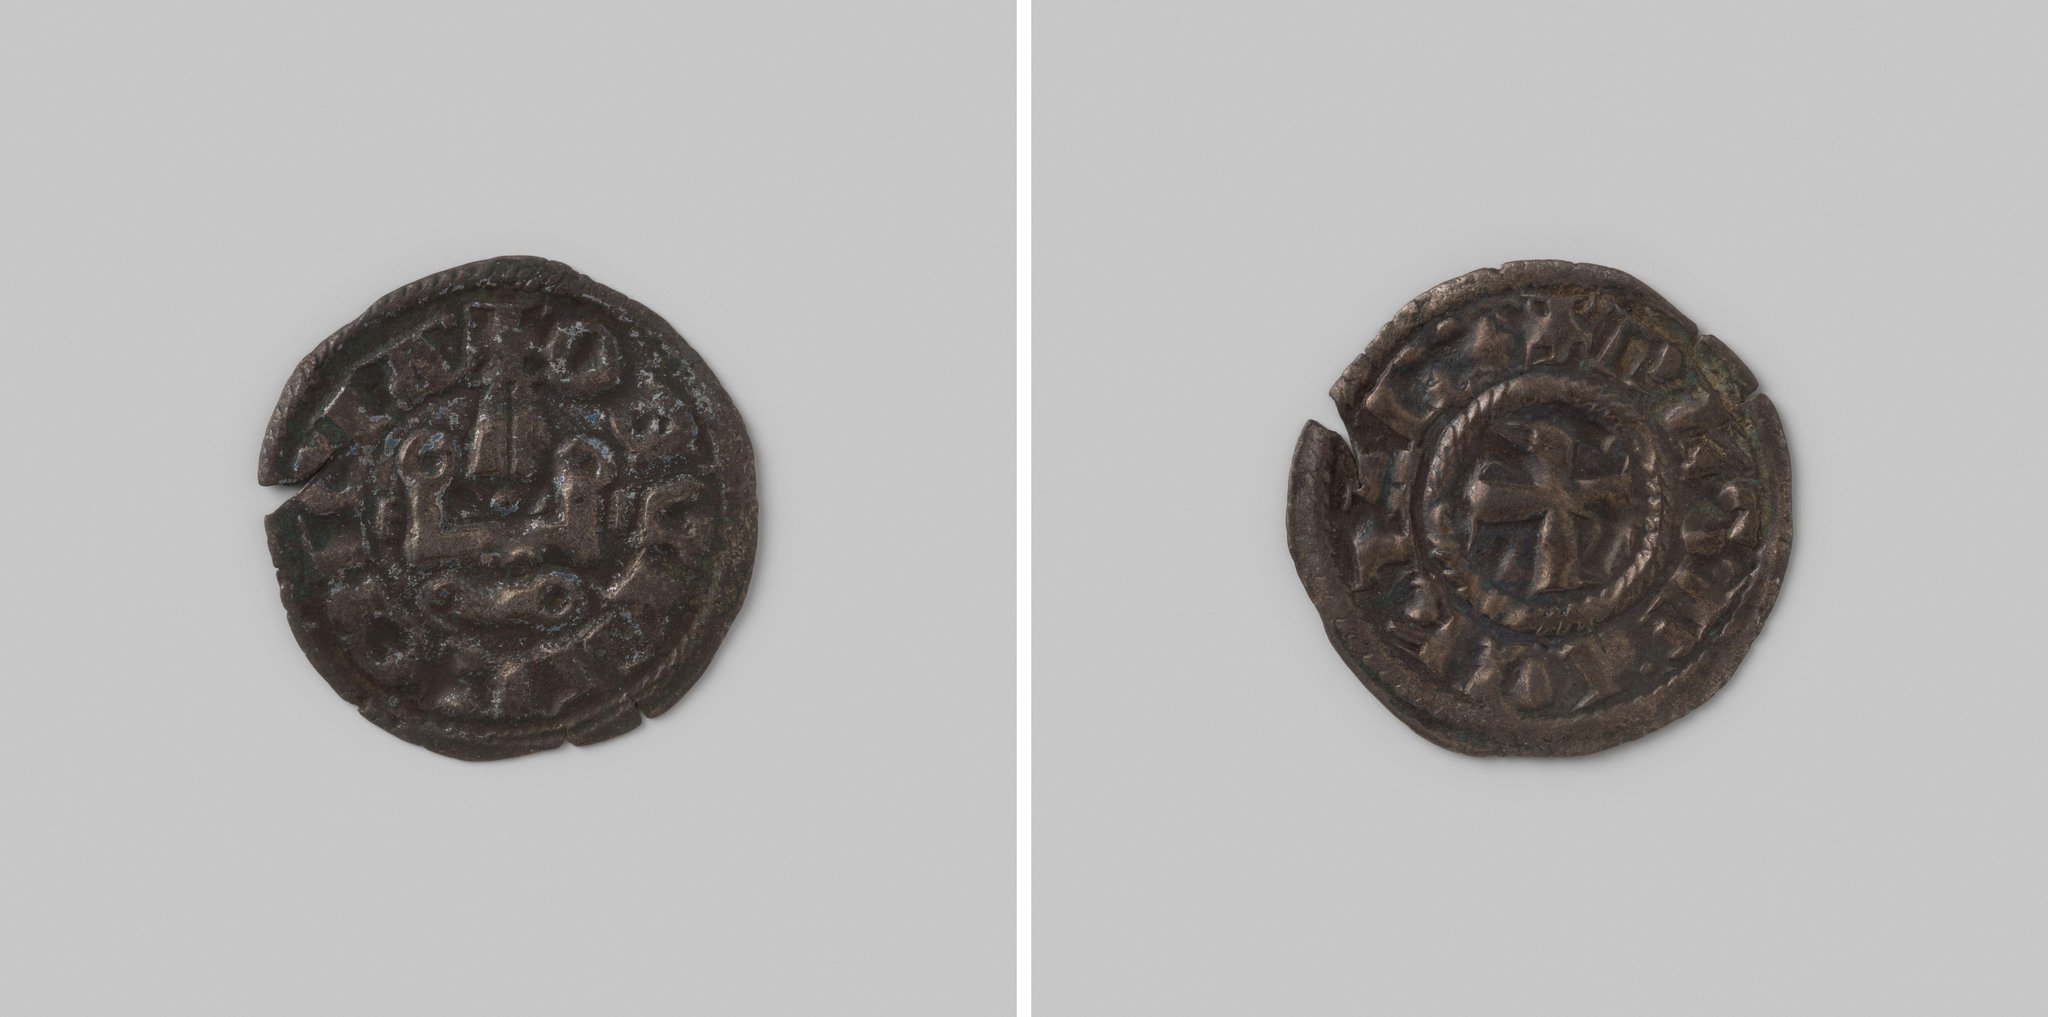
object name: coin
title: Tourse penning uit het vorstendom Achaea van Robert van Anjou, 1346-1364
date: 1346-1364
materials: silver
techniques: striking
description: Zilveren munt. Voorzijde: kasteel met drie torens. Boven middelste, spitse toren kruis als begin van het omschrift. Keerzijde: kort gevoet kruis. Geslagen in Clarenza.